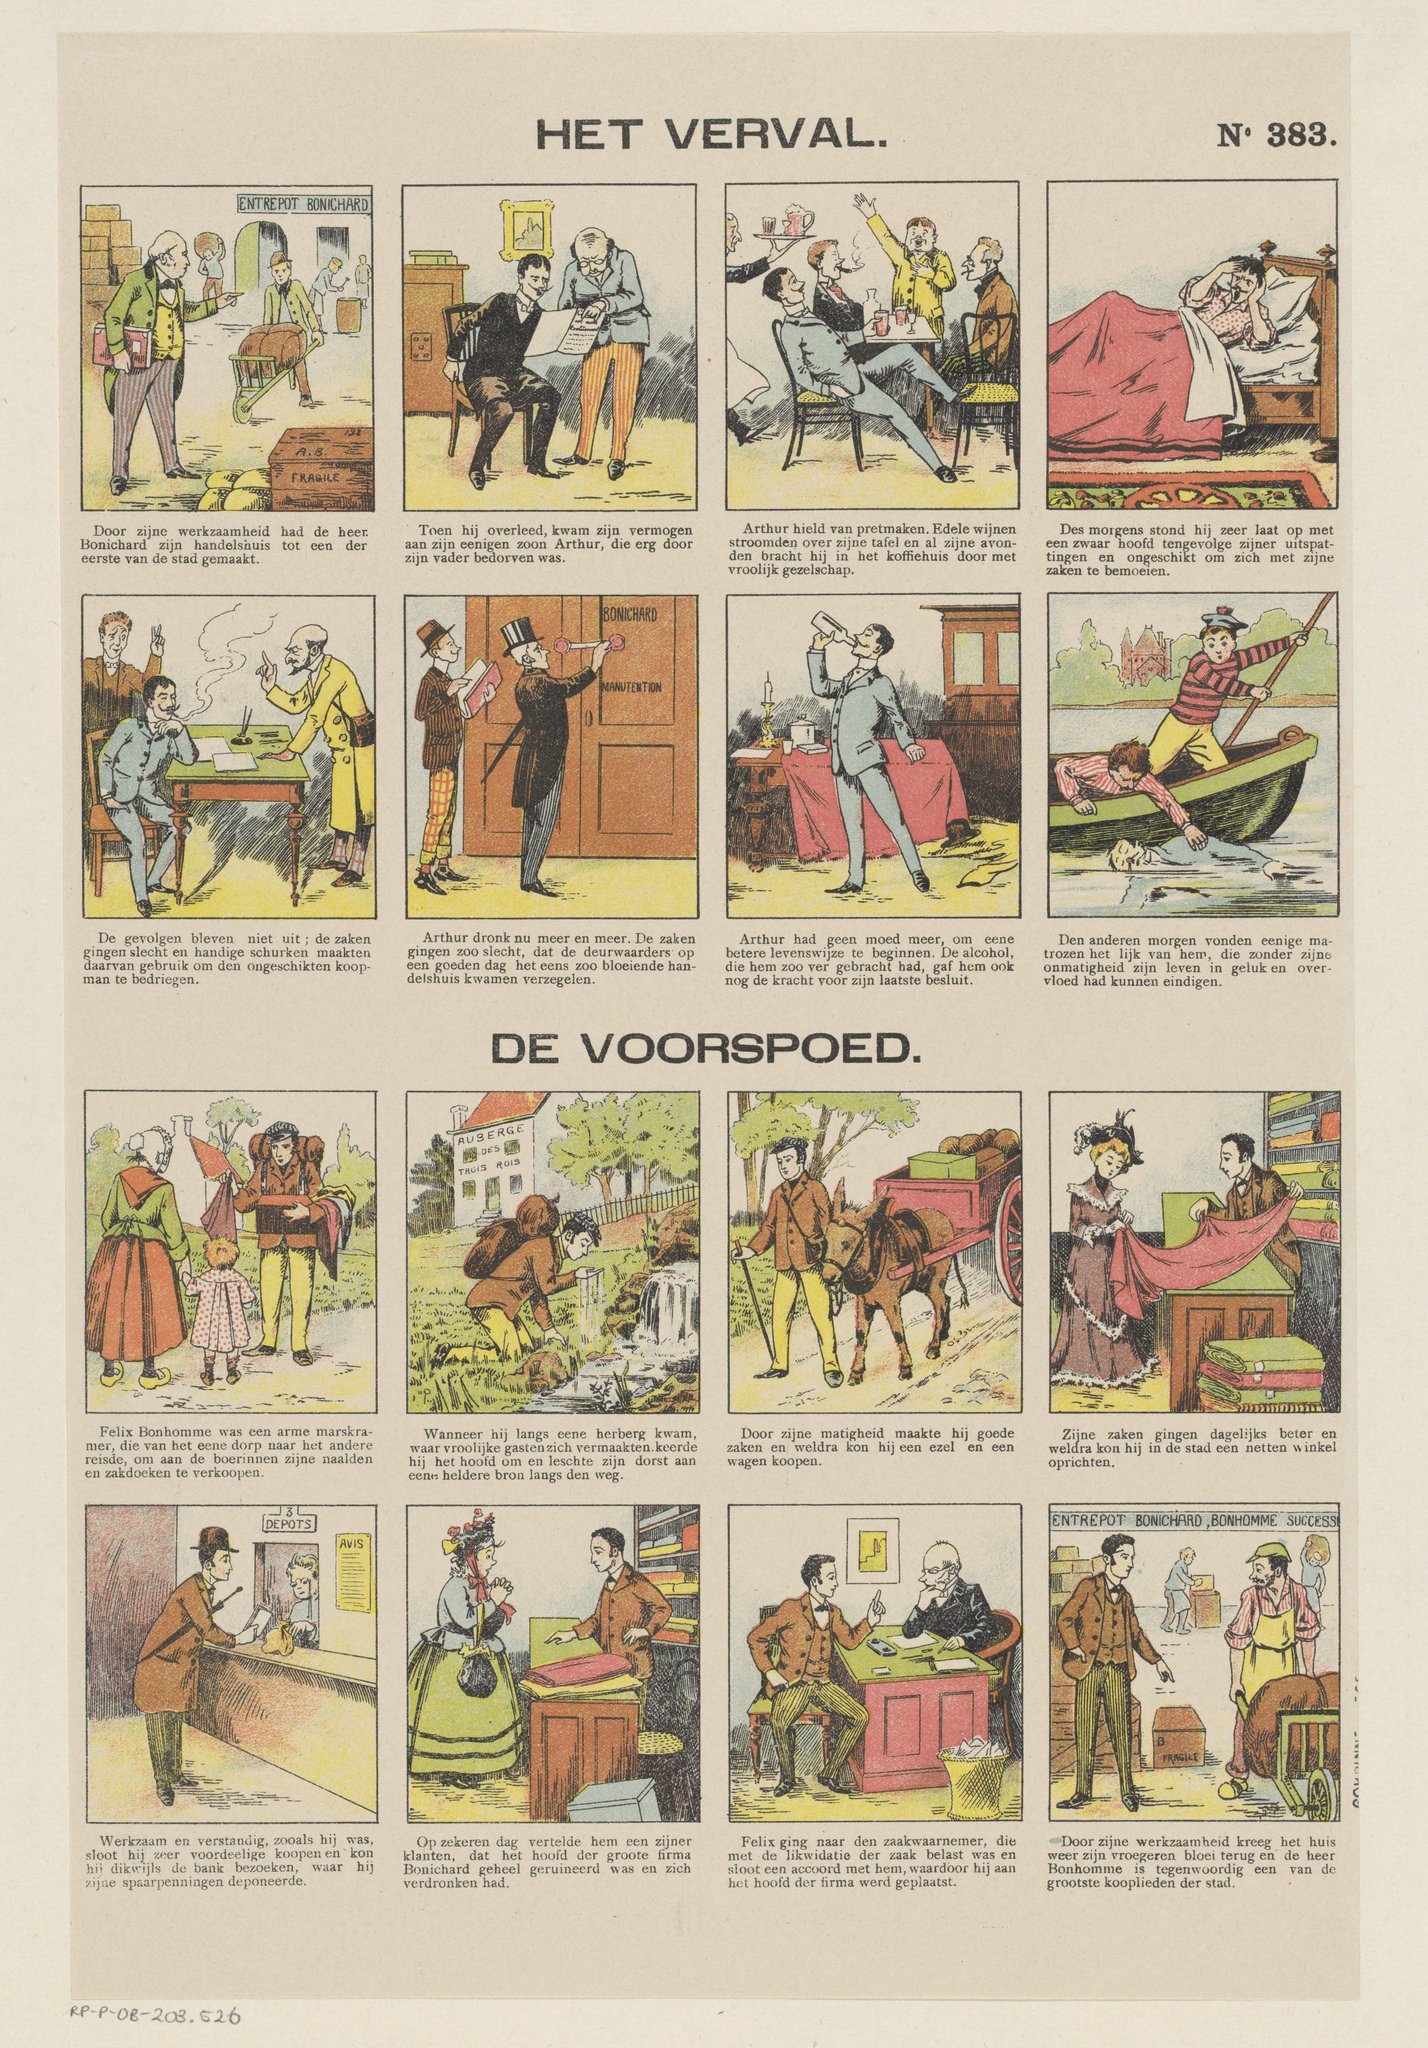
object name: print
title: Het verval / De voorspoed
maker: Anonymous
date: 1894-1959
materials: paper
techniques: lithograph, letterpress printing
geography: liège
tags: drunkard, bad behaviour, good behaviour, drunkenness, suicide out of despair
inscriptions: collector's mark: Lugt 2760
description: Blad met 16 voorstellingen. Boven acht voorstellingen over Arthur die door teveel drinken zijn bedrijf ten onder laat gaan. Onder acht voorstellingen over Felix Bonhomme die steeds hogerop klimt en uiteindelijk het bedrijf van Arthur koopt. Onder elke afbeelding een onderschrift. Genummerd rechtsboven: No 383.